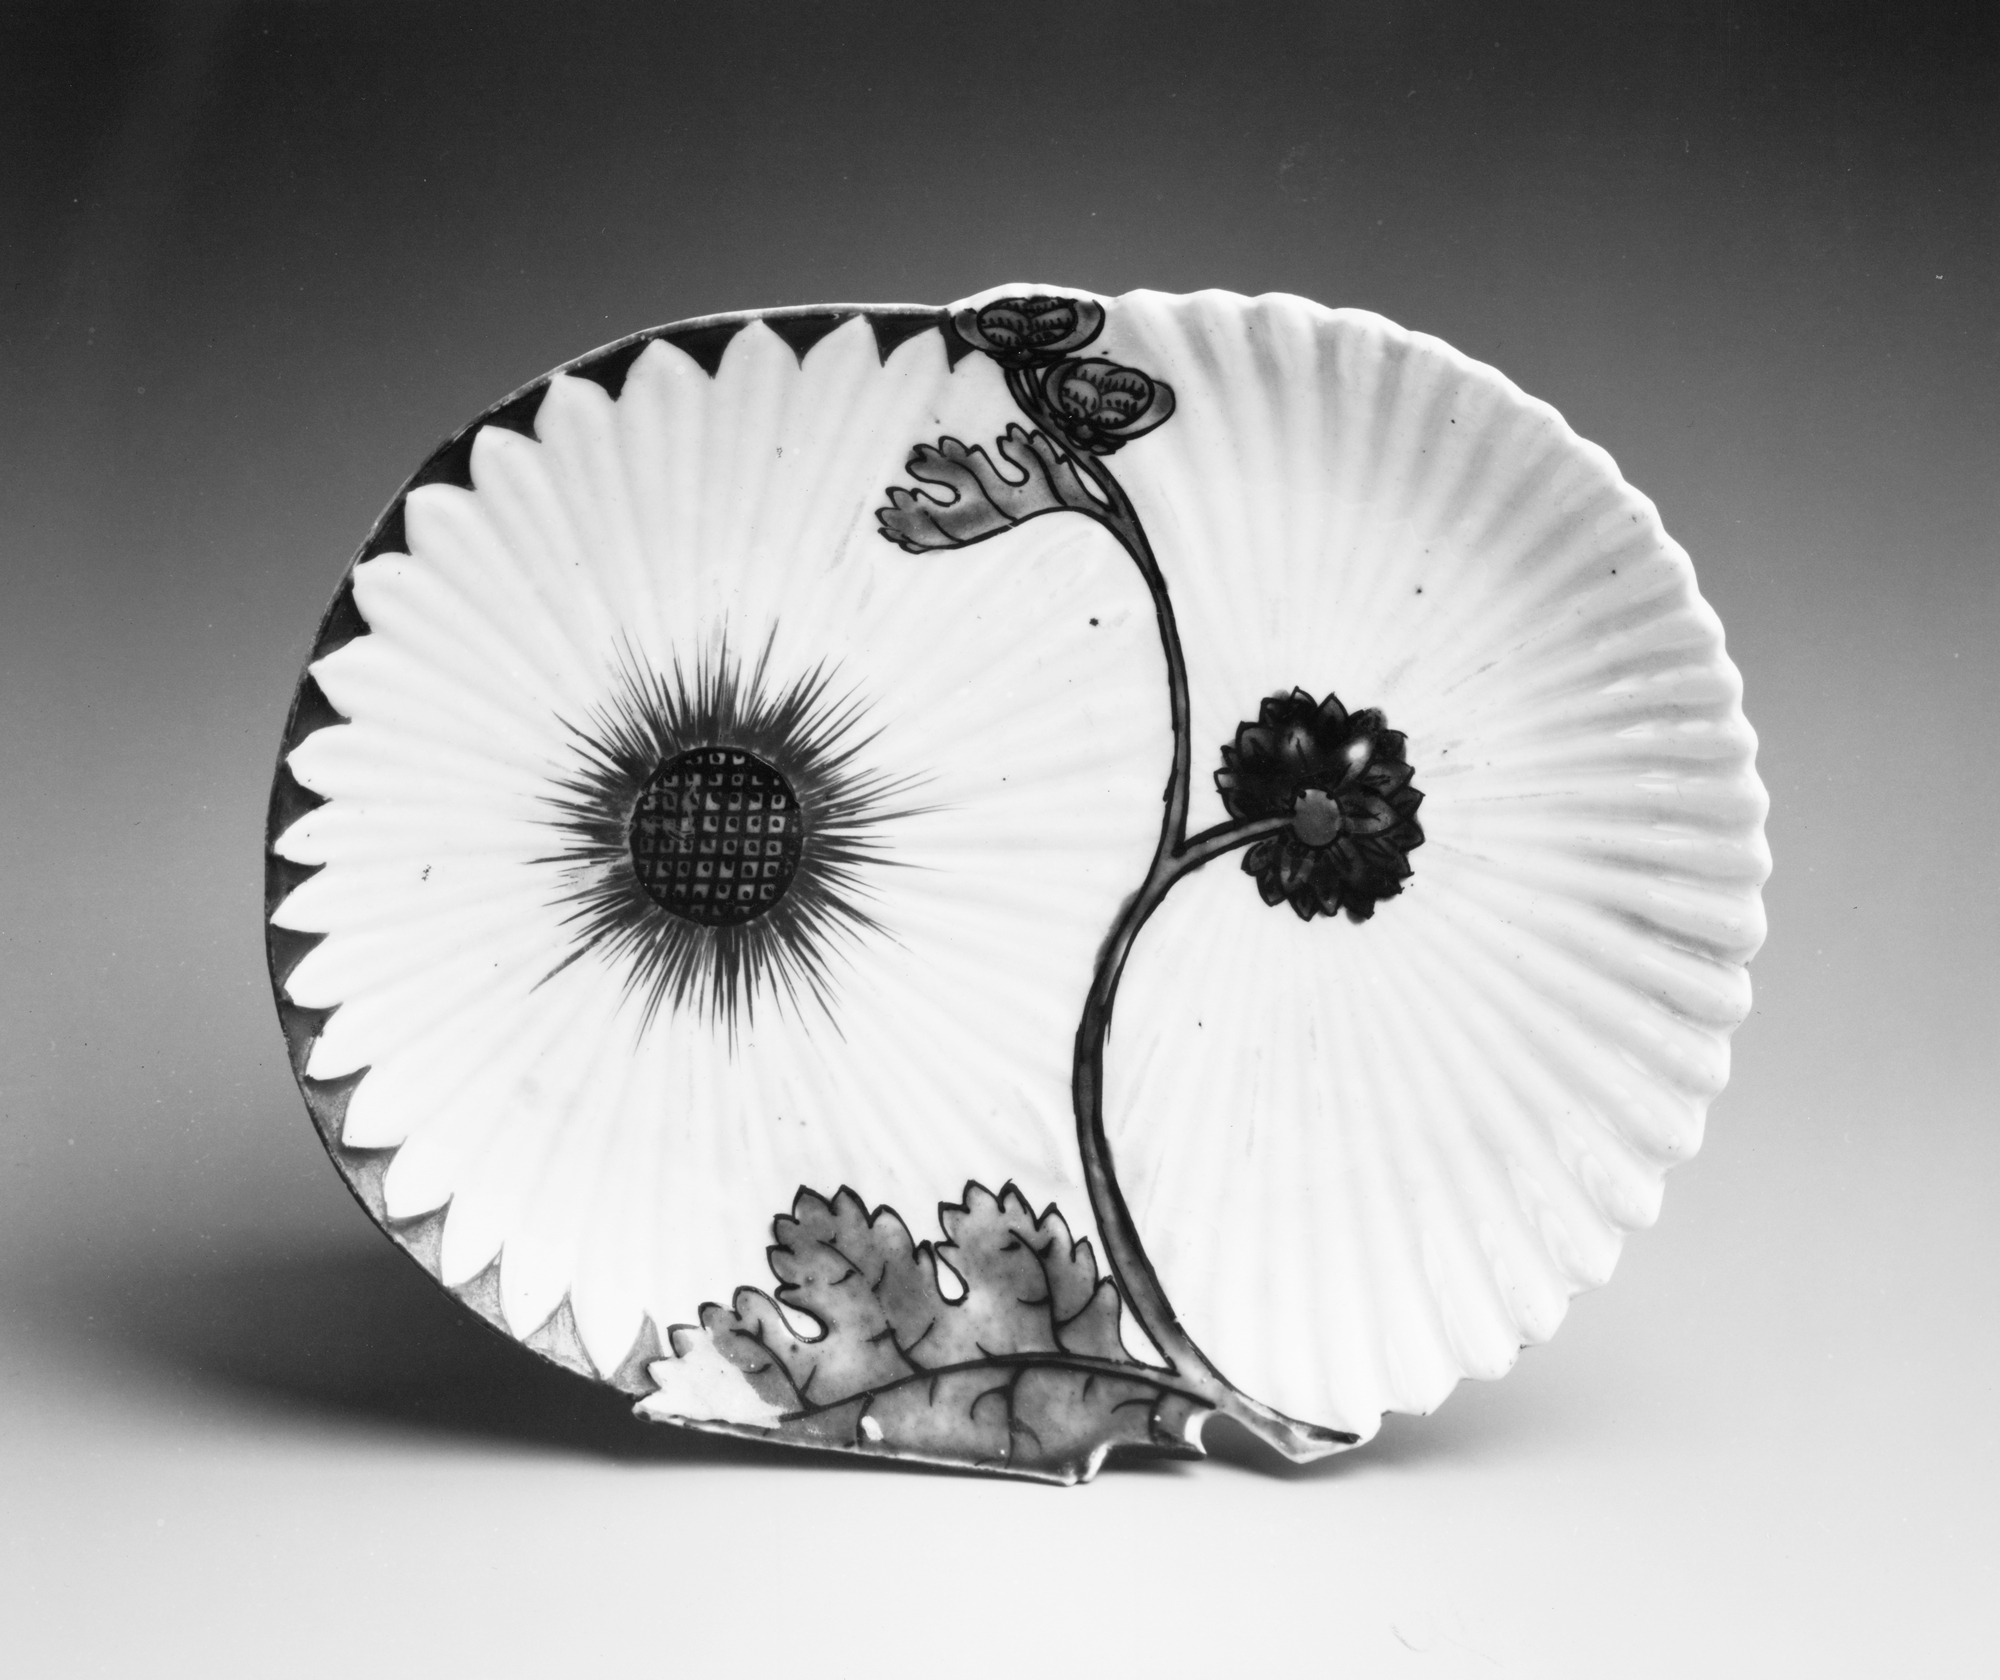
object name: dish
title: Molded Dish with Chrysanthemum Design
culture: japanese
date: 1650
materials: enamel, porcelain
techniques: overglaze, painting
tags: flowers